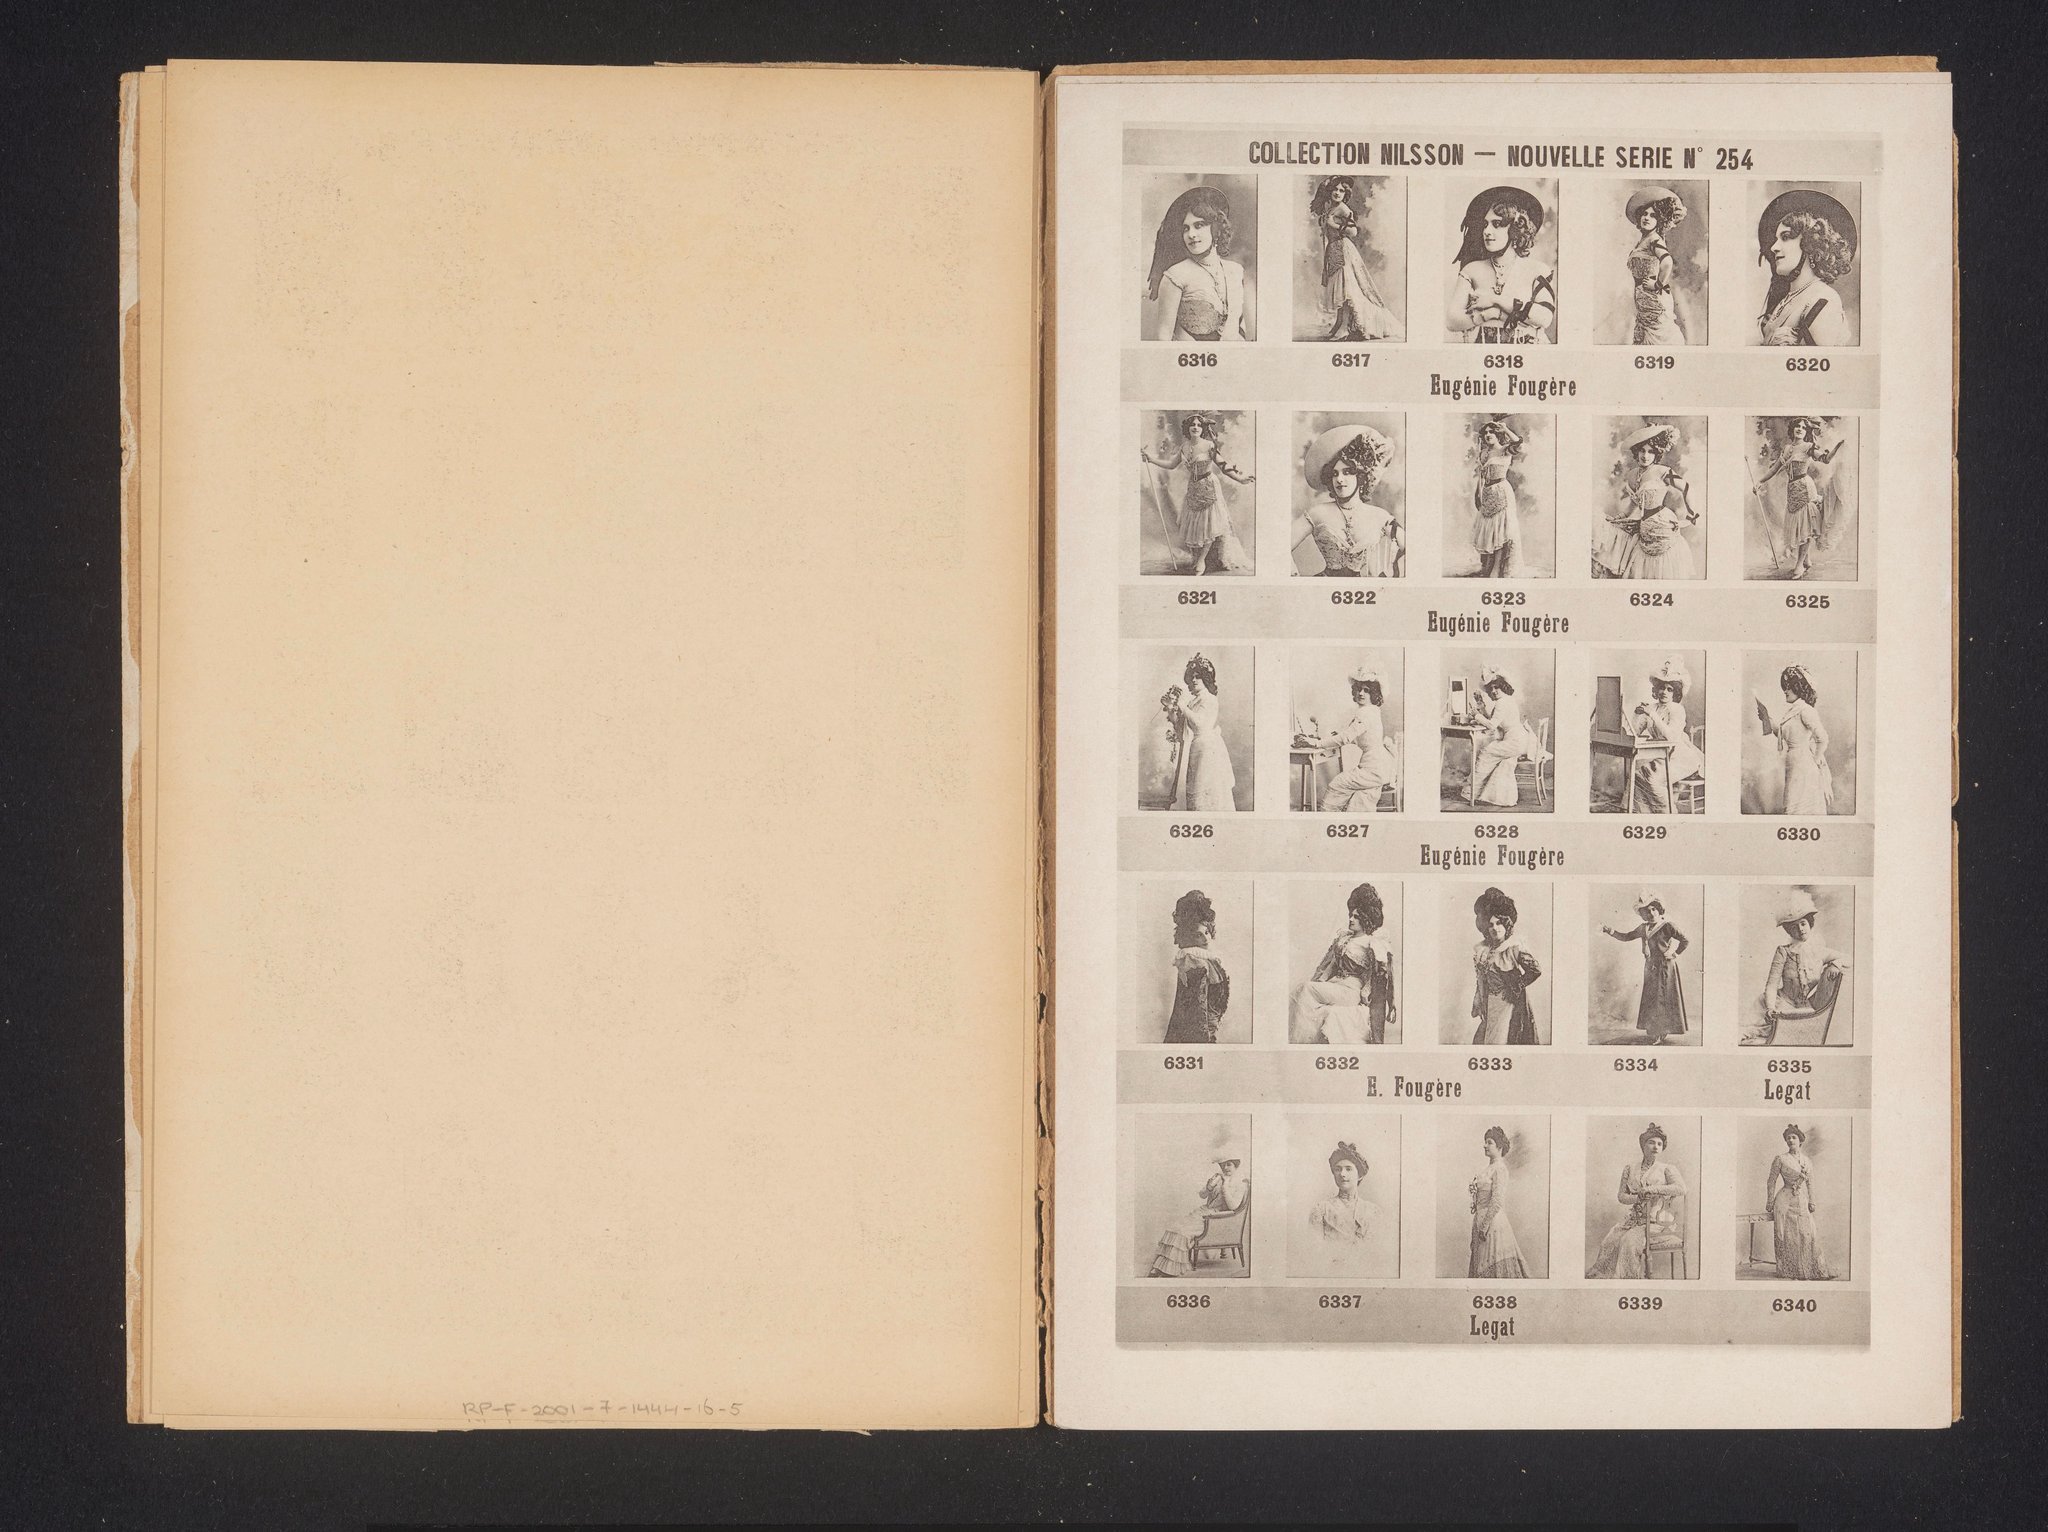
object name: page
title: 25 portretten van Eugenie Fougère en Legat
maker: Anonymous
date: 1894-1899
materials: paper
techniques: photograph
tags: historical persons - bb - woman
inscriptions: number: ‘No 254’